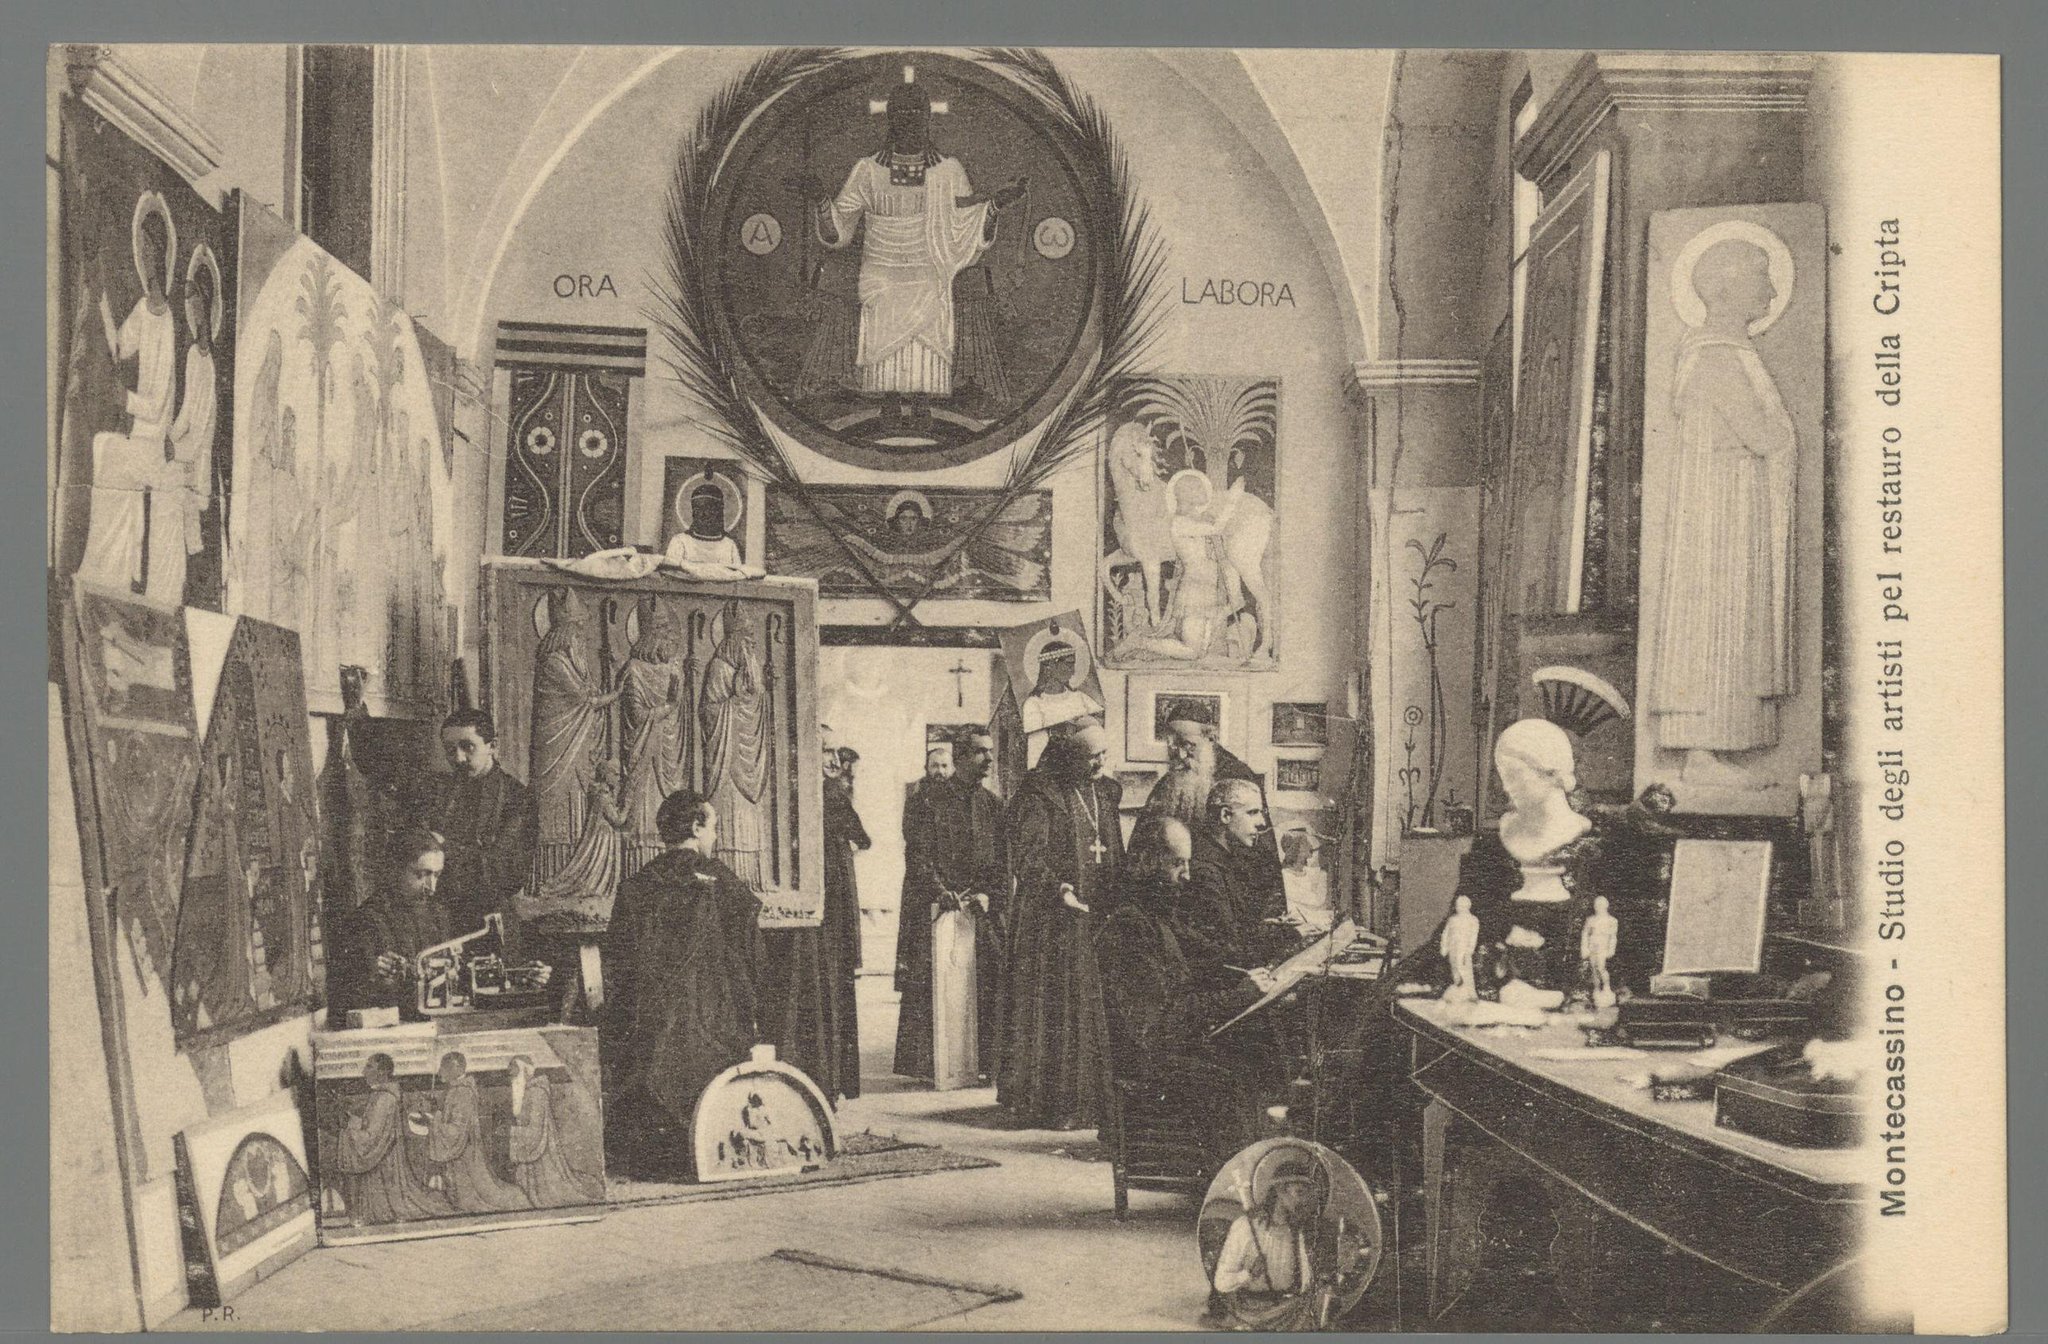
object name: photomechanical print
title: Montecassino. Studio degli artisti pel restauro della Cripta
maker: Anonymous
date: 1906-1910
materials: cardboard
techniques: photograph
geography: terni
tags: abbey, monastery, convent ~ roman catholic church, picture, painting, artist at work, in his workshop